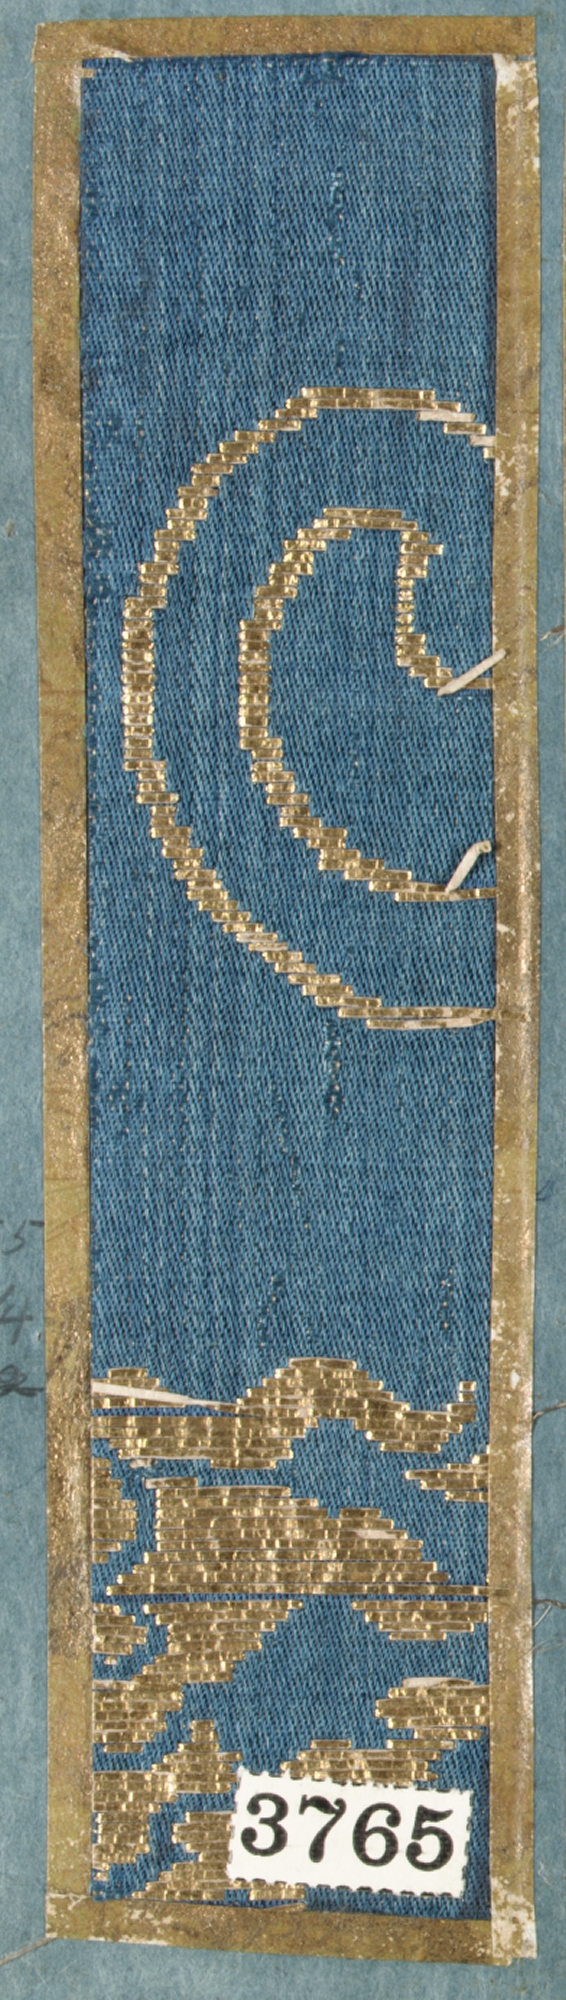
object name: sample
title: Textile Sample from Sample Book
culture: japanese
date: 1801-1900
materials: silk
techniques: tapestry